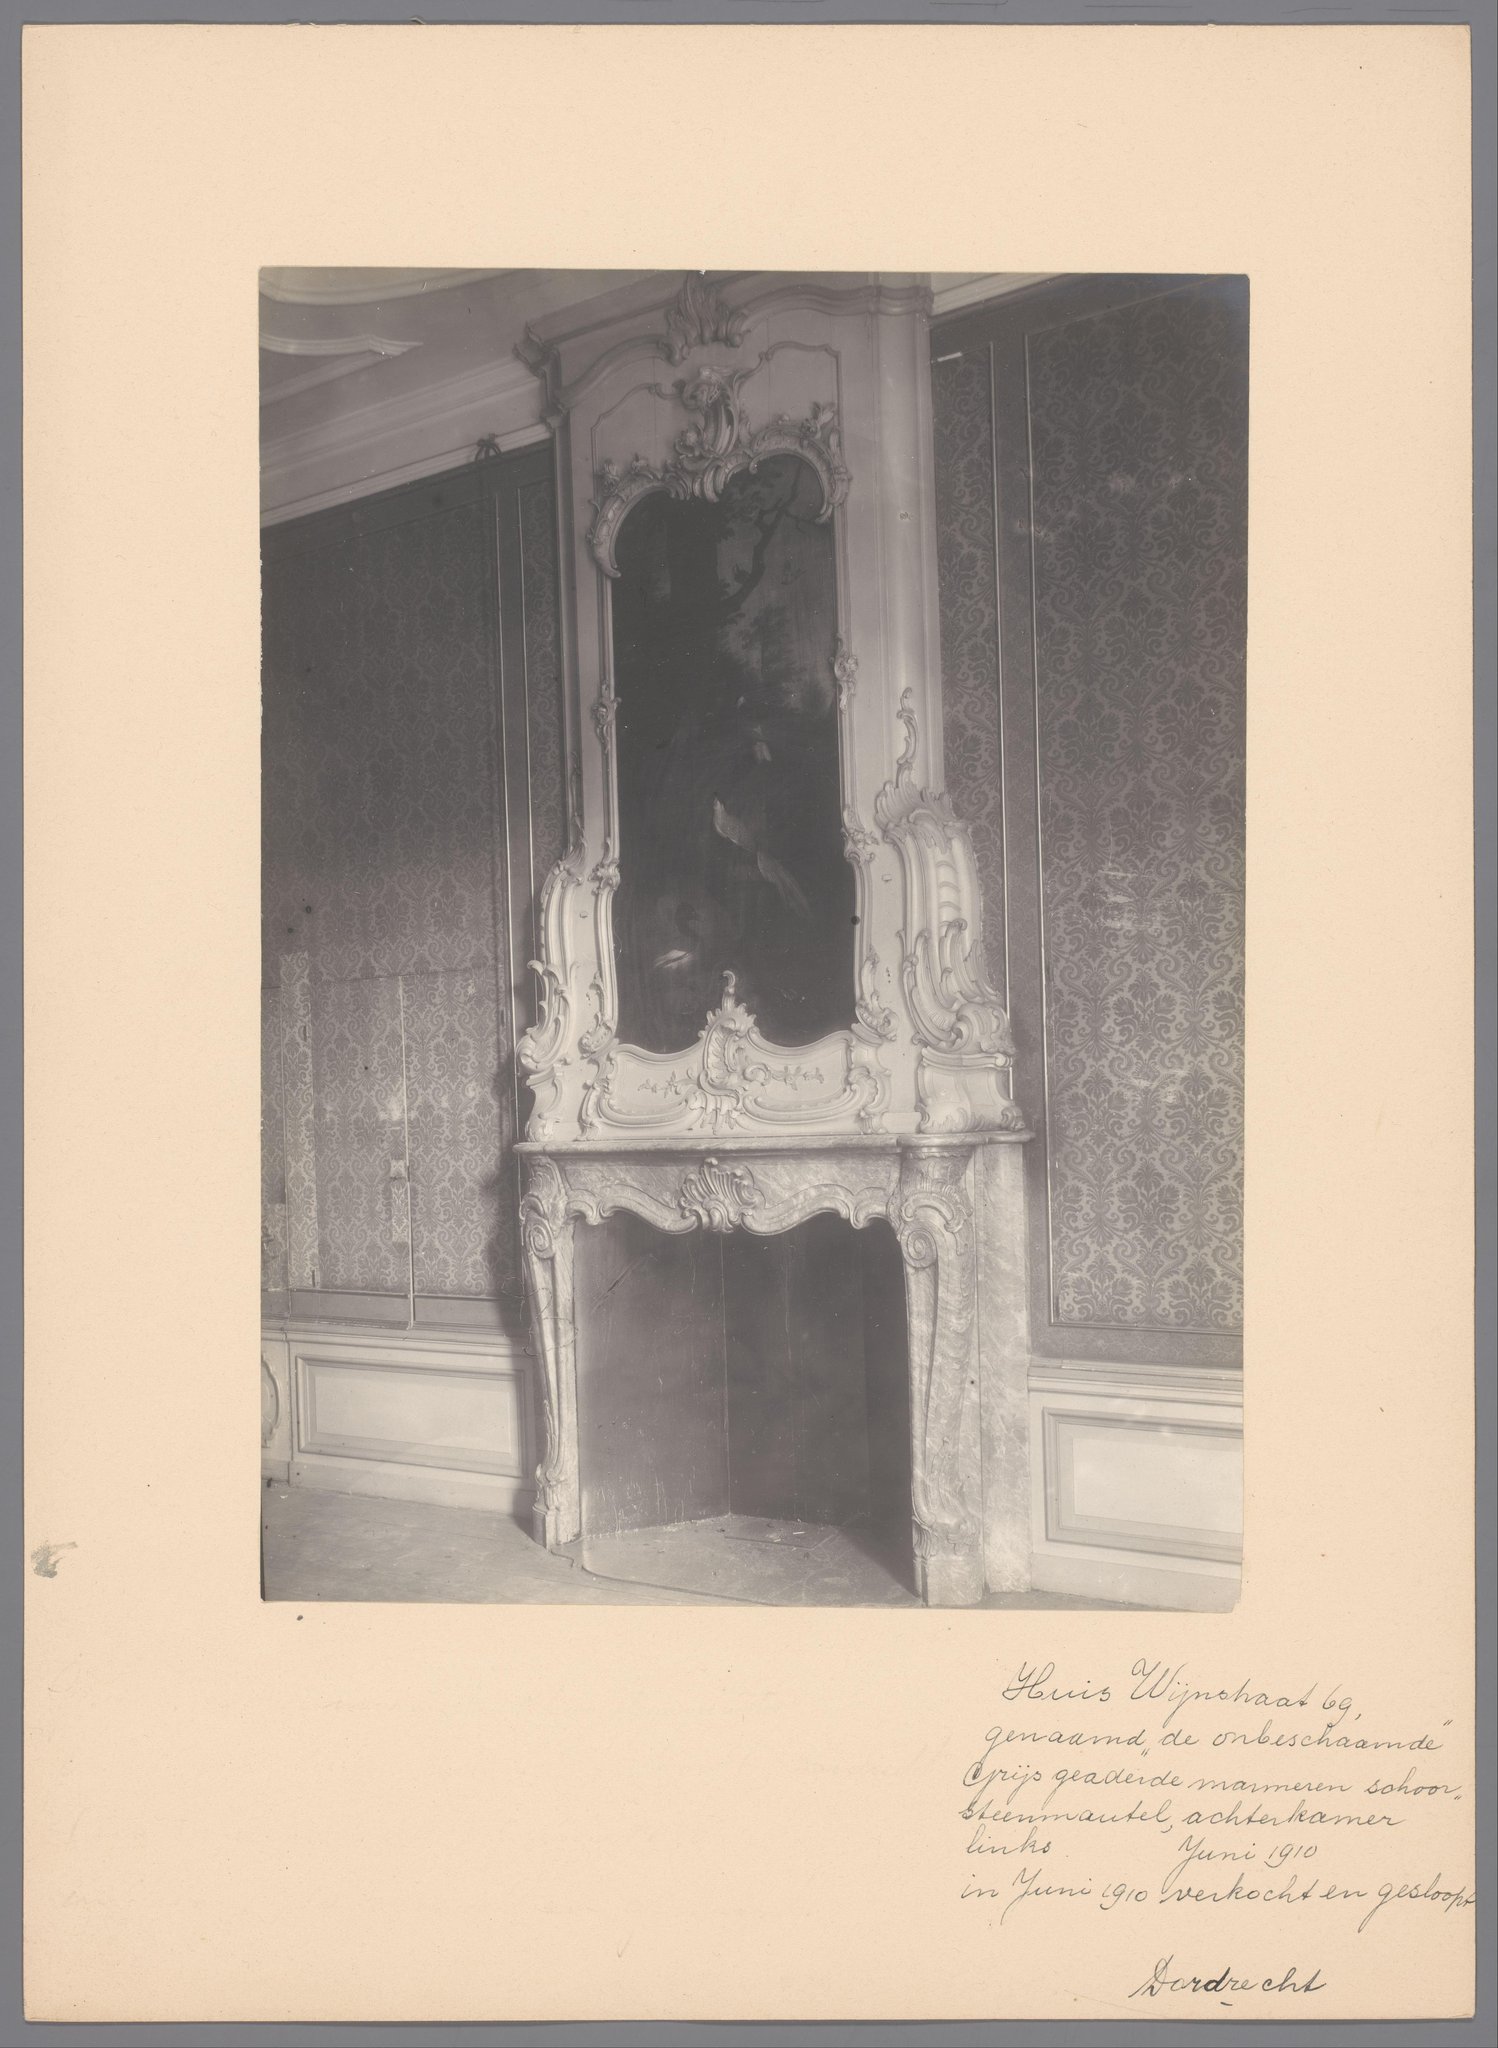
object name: photograph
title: Interieur met een marmeren schoorsteenmantel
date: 1910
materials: cardboard, photographic support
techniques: gelatin silver print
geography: wijnstraat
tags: open hearth, fire-place, interior of the house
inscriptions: annotation: ‘Huis Wijnstraat 69, genaamd "de onbeschaamde/ grijs geaderde marmeren schoorsteenmantel, achterkamer links/ Juni 1910/ in Juni 1910 verkocht en gesloopt/ Dordrecht’